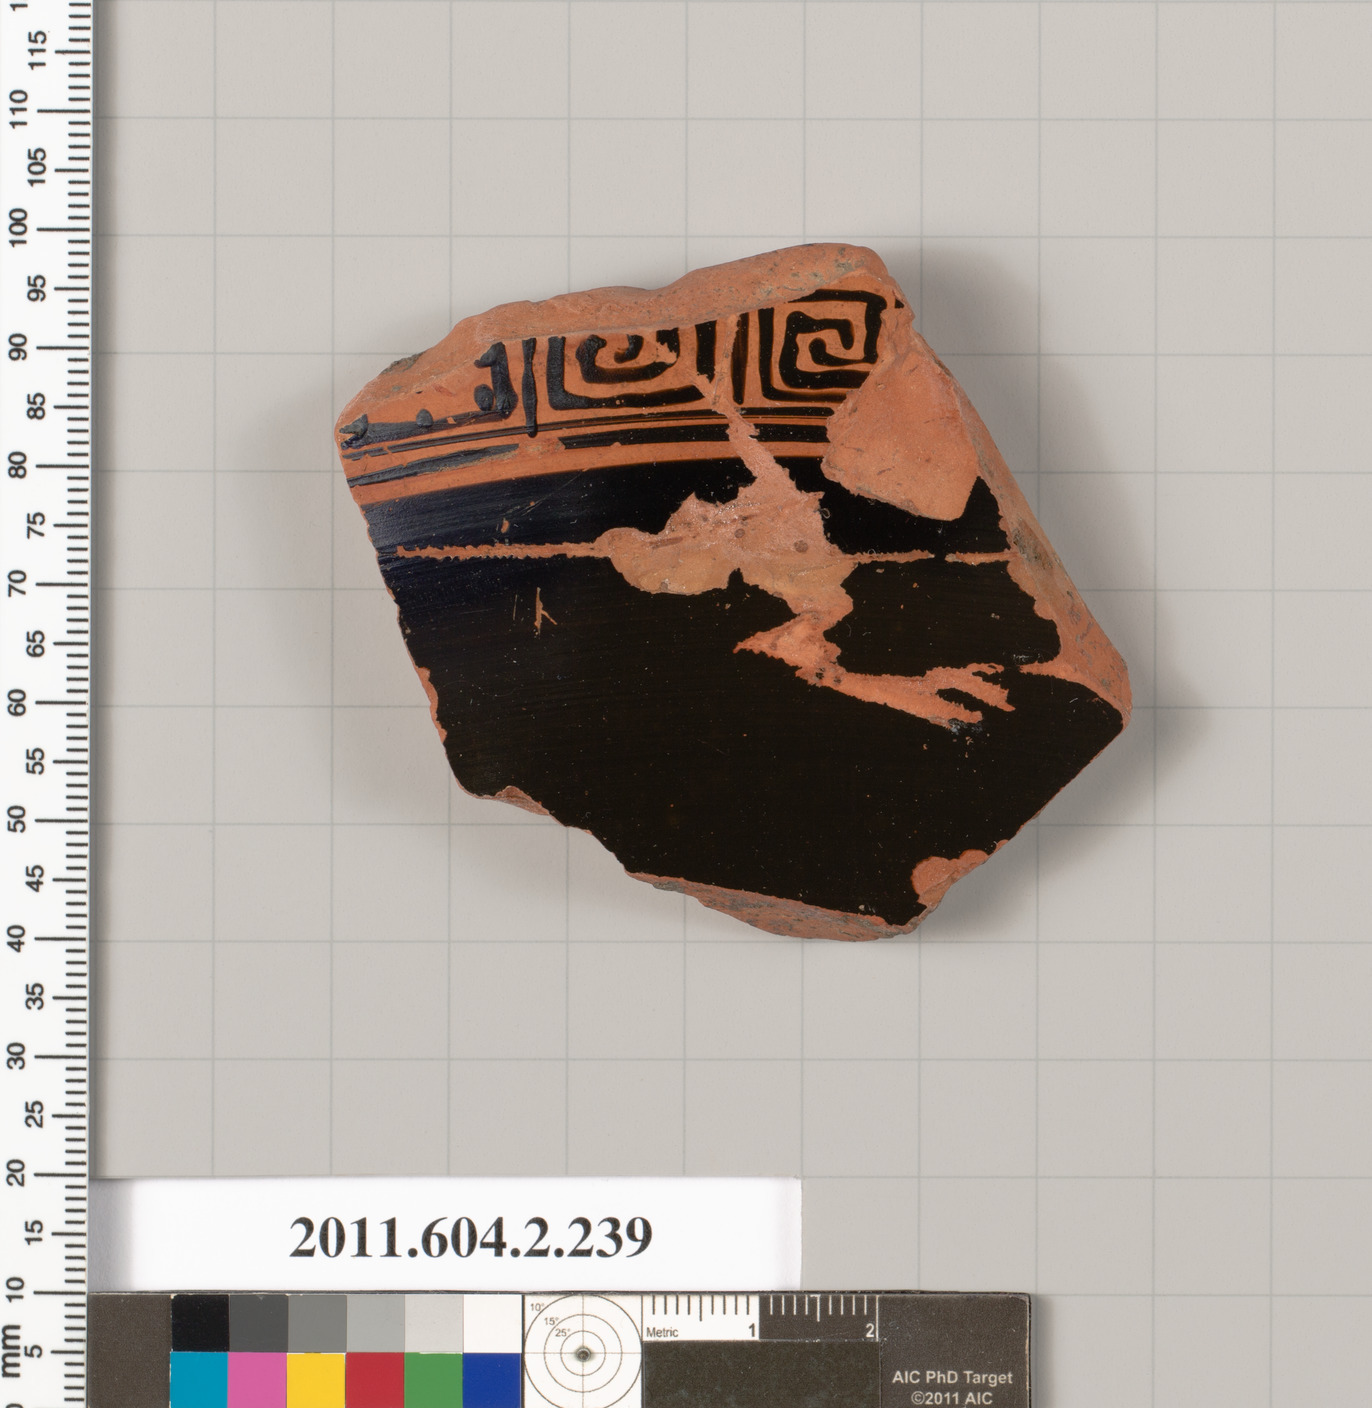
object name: stamnos fragment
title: Terracotta fragment of a stamnos (jar)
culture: greek, attic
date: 460-440 BCE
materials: terracotta